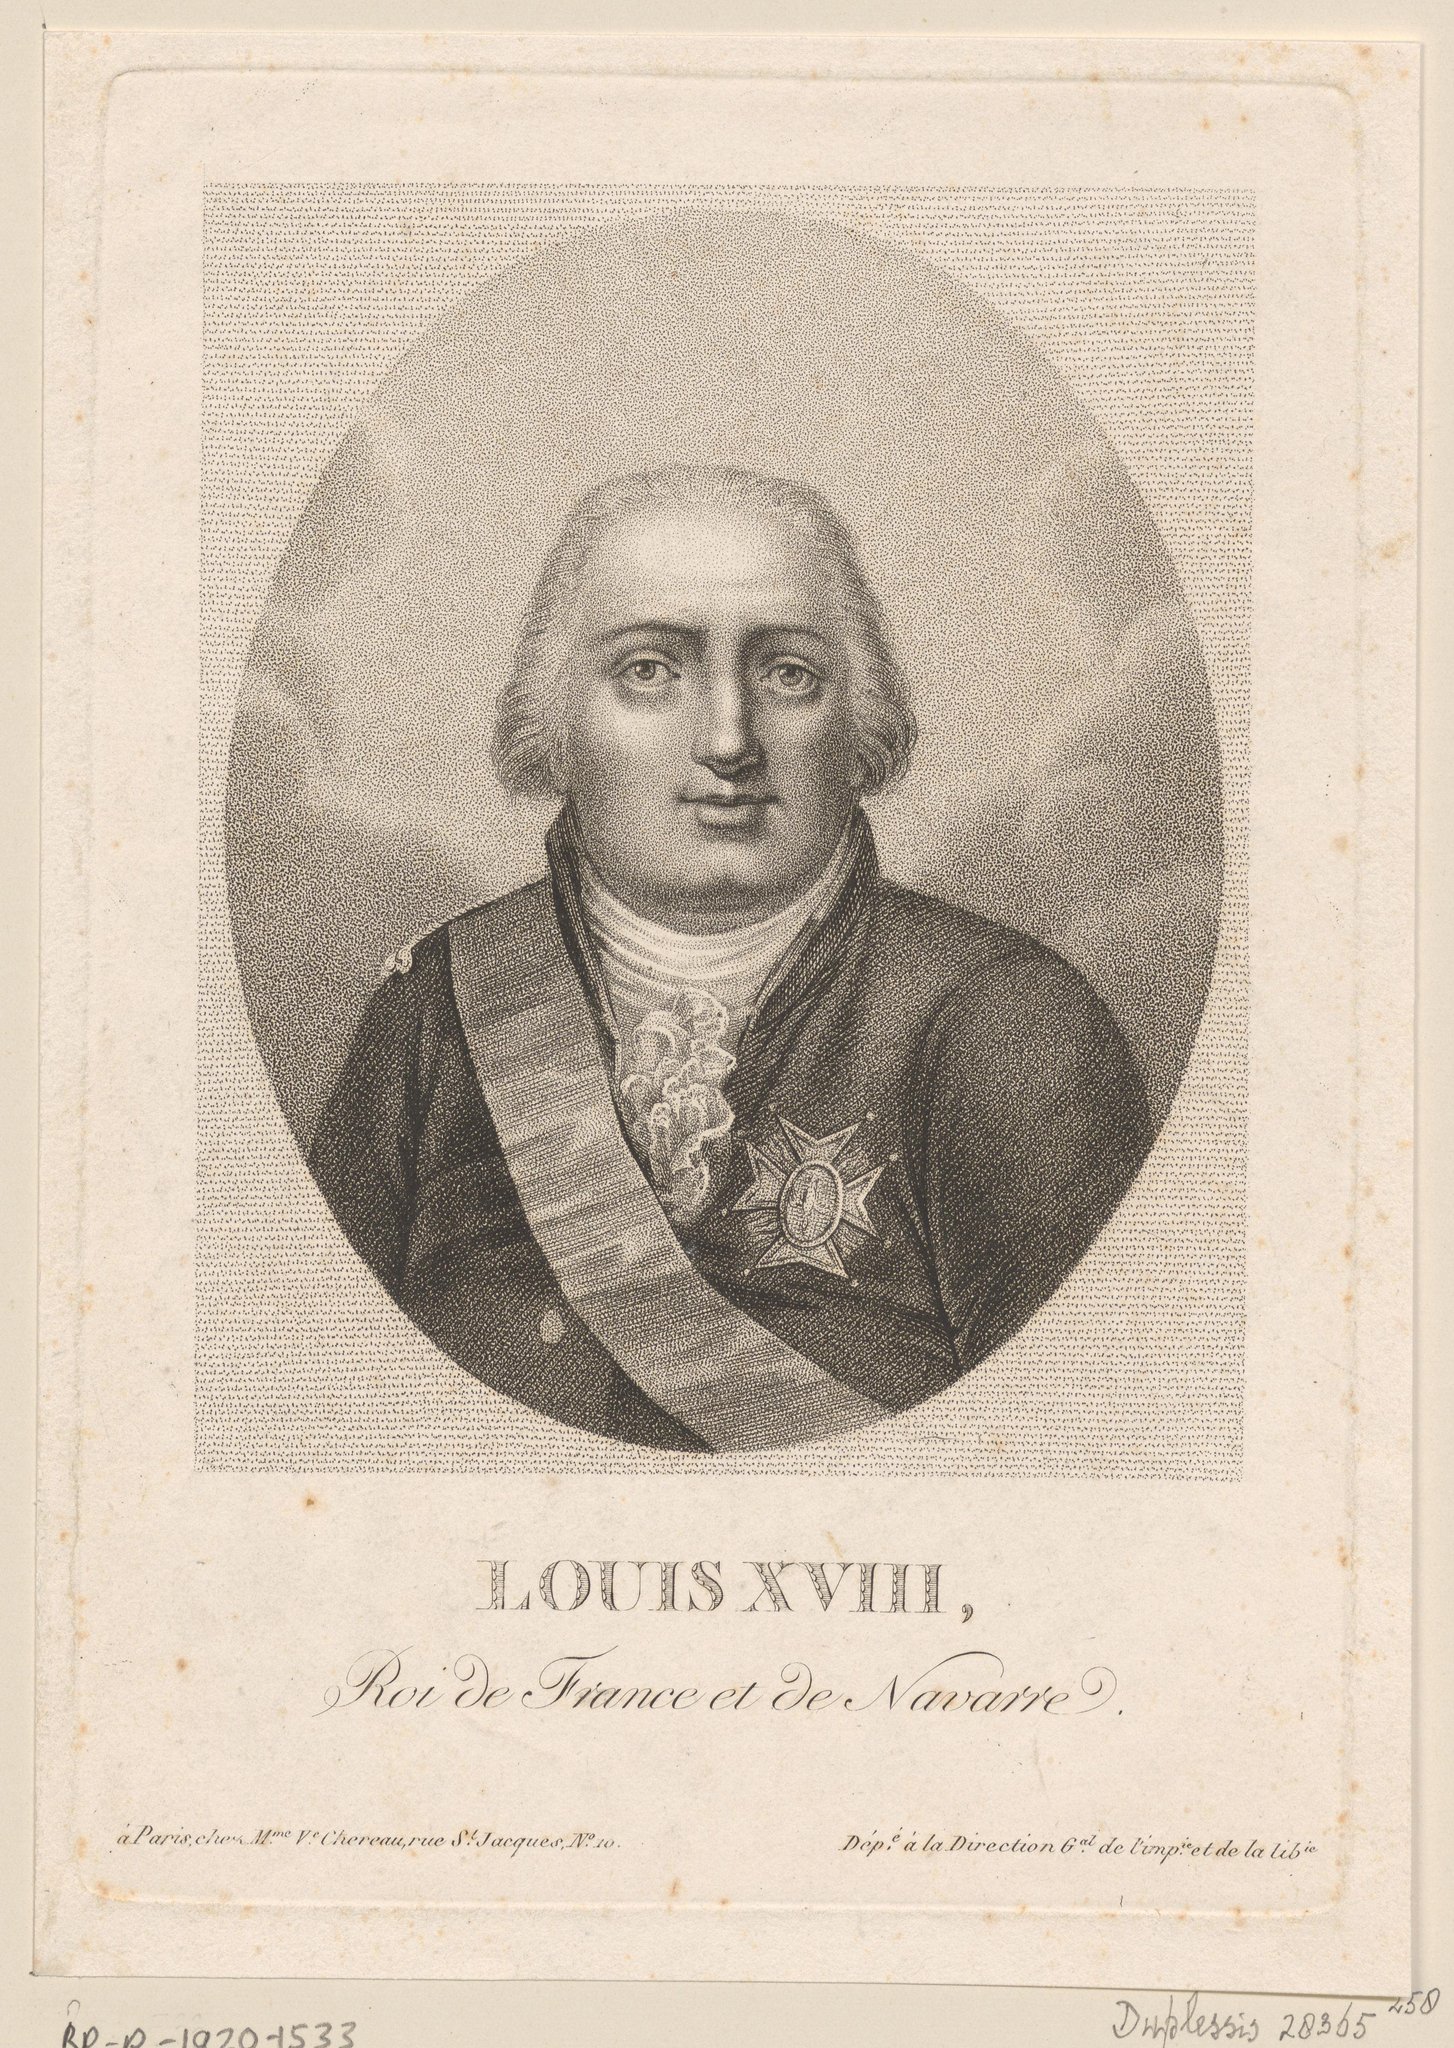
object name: print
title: Portret van Lodewijk XVIII van Frankrijk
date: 1814-1824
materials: paper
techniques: stippling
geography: france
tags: paris, lodewijk xviii (koning van frankrijk), historical persons, king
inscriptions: collector's mark: Lugt 2228, : ‘Dép.é à la Direction G.al de l'imp.ie et de la libie’, inscription: ‘April 1841 [sic] door het P[...] Gouvernement/ tot koning van Frankrijk geproclameerd’